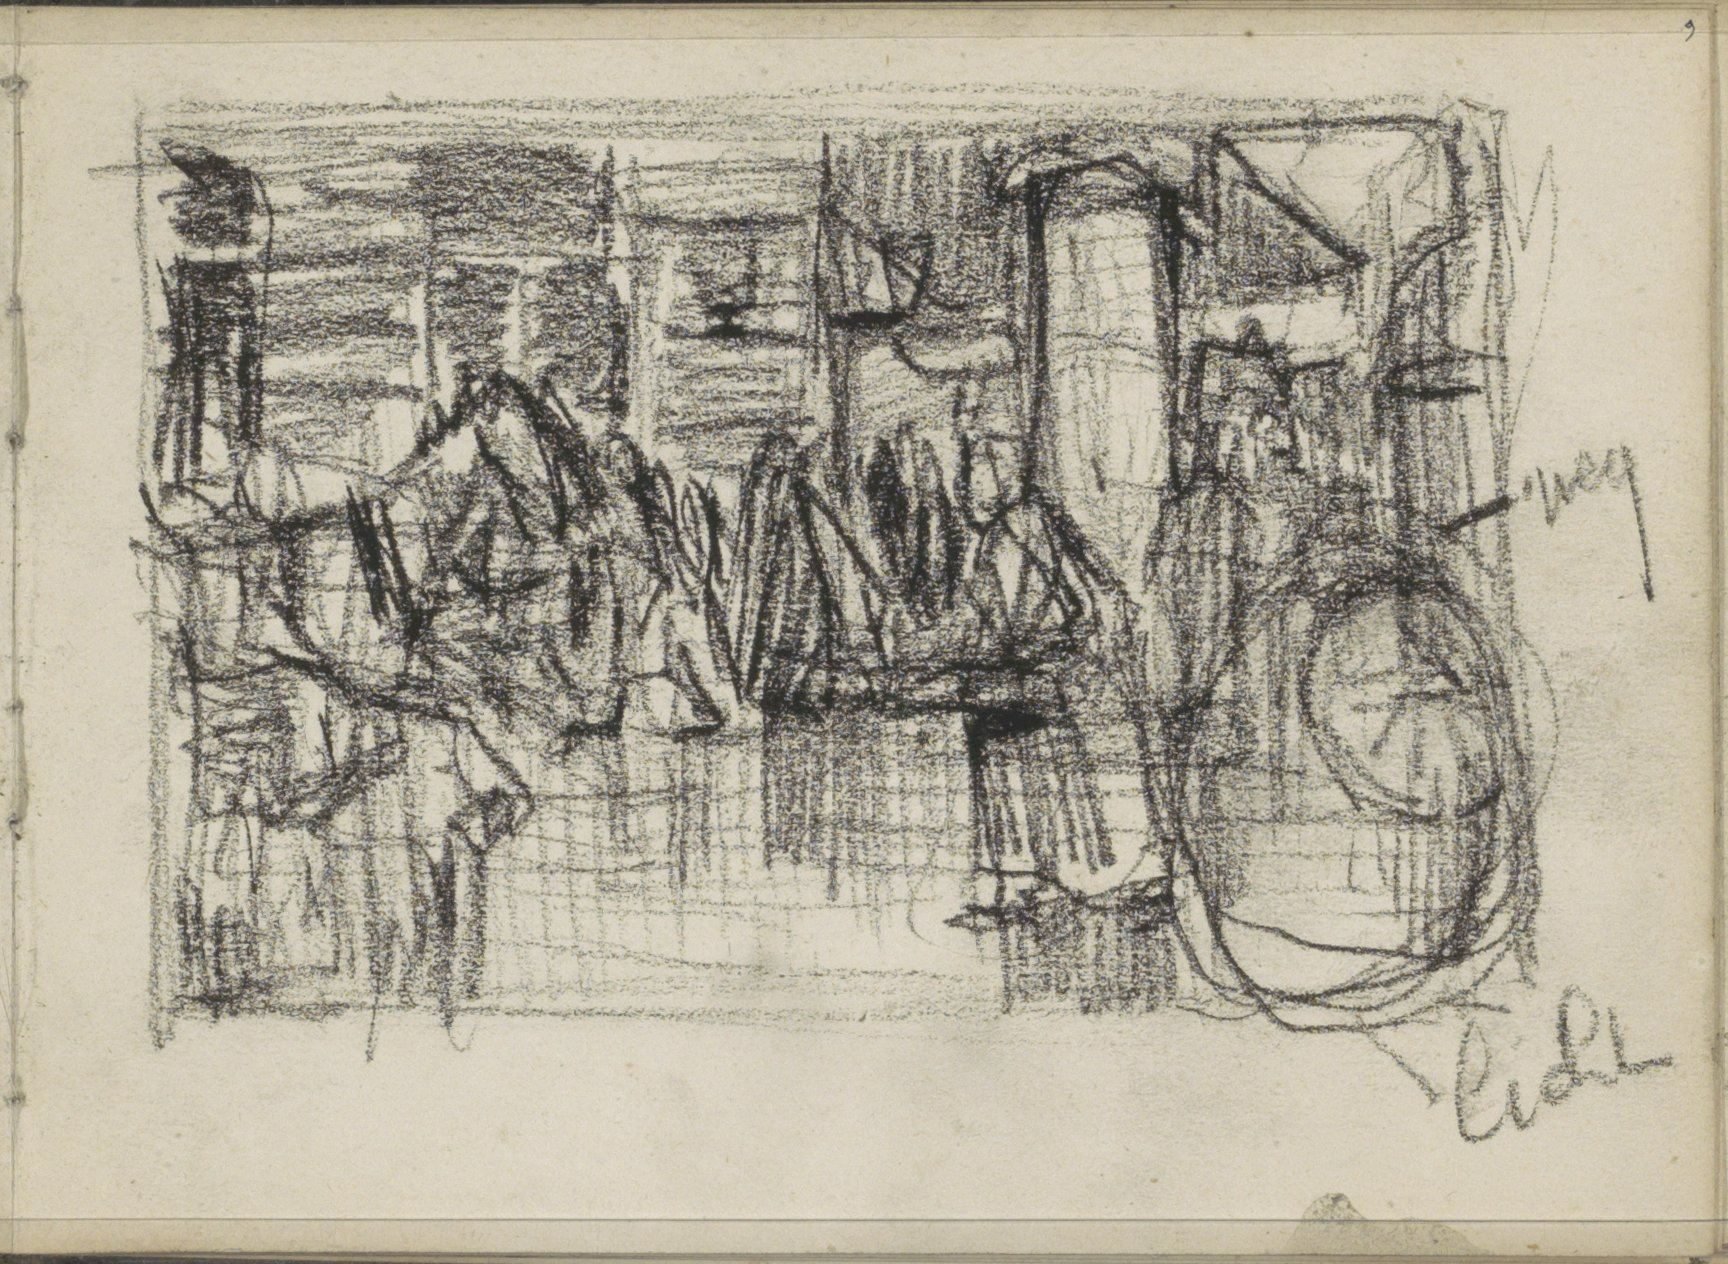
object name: sketchbook leaf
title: Straat met figuren en een paard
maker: marius bauer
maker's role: draughtsman, print maker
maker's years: 1867-1932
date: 1877-1932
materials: chalk, paper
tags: horse, street (+ city(-scape) with figures, staffage)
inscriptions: kleurnotitie, handgeschreven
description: Pagina 9 uit een schetsboek met 32 bladen.